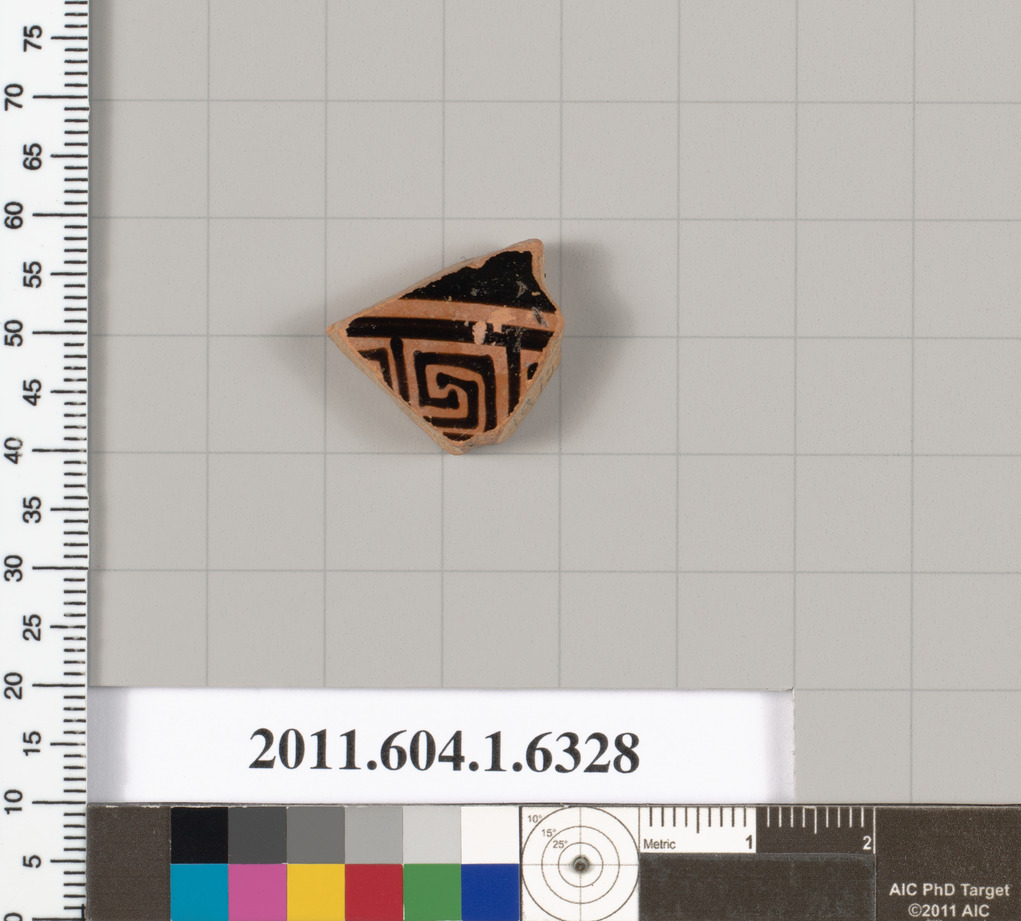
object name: kylix fragment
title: Terracotta fragment of a kylix (drinking cup)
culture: greek, attic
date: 500-480 BCE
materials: terracotta